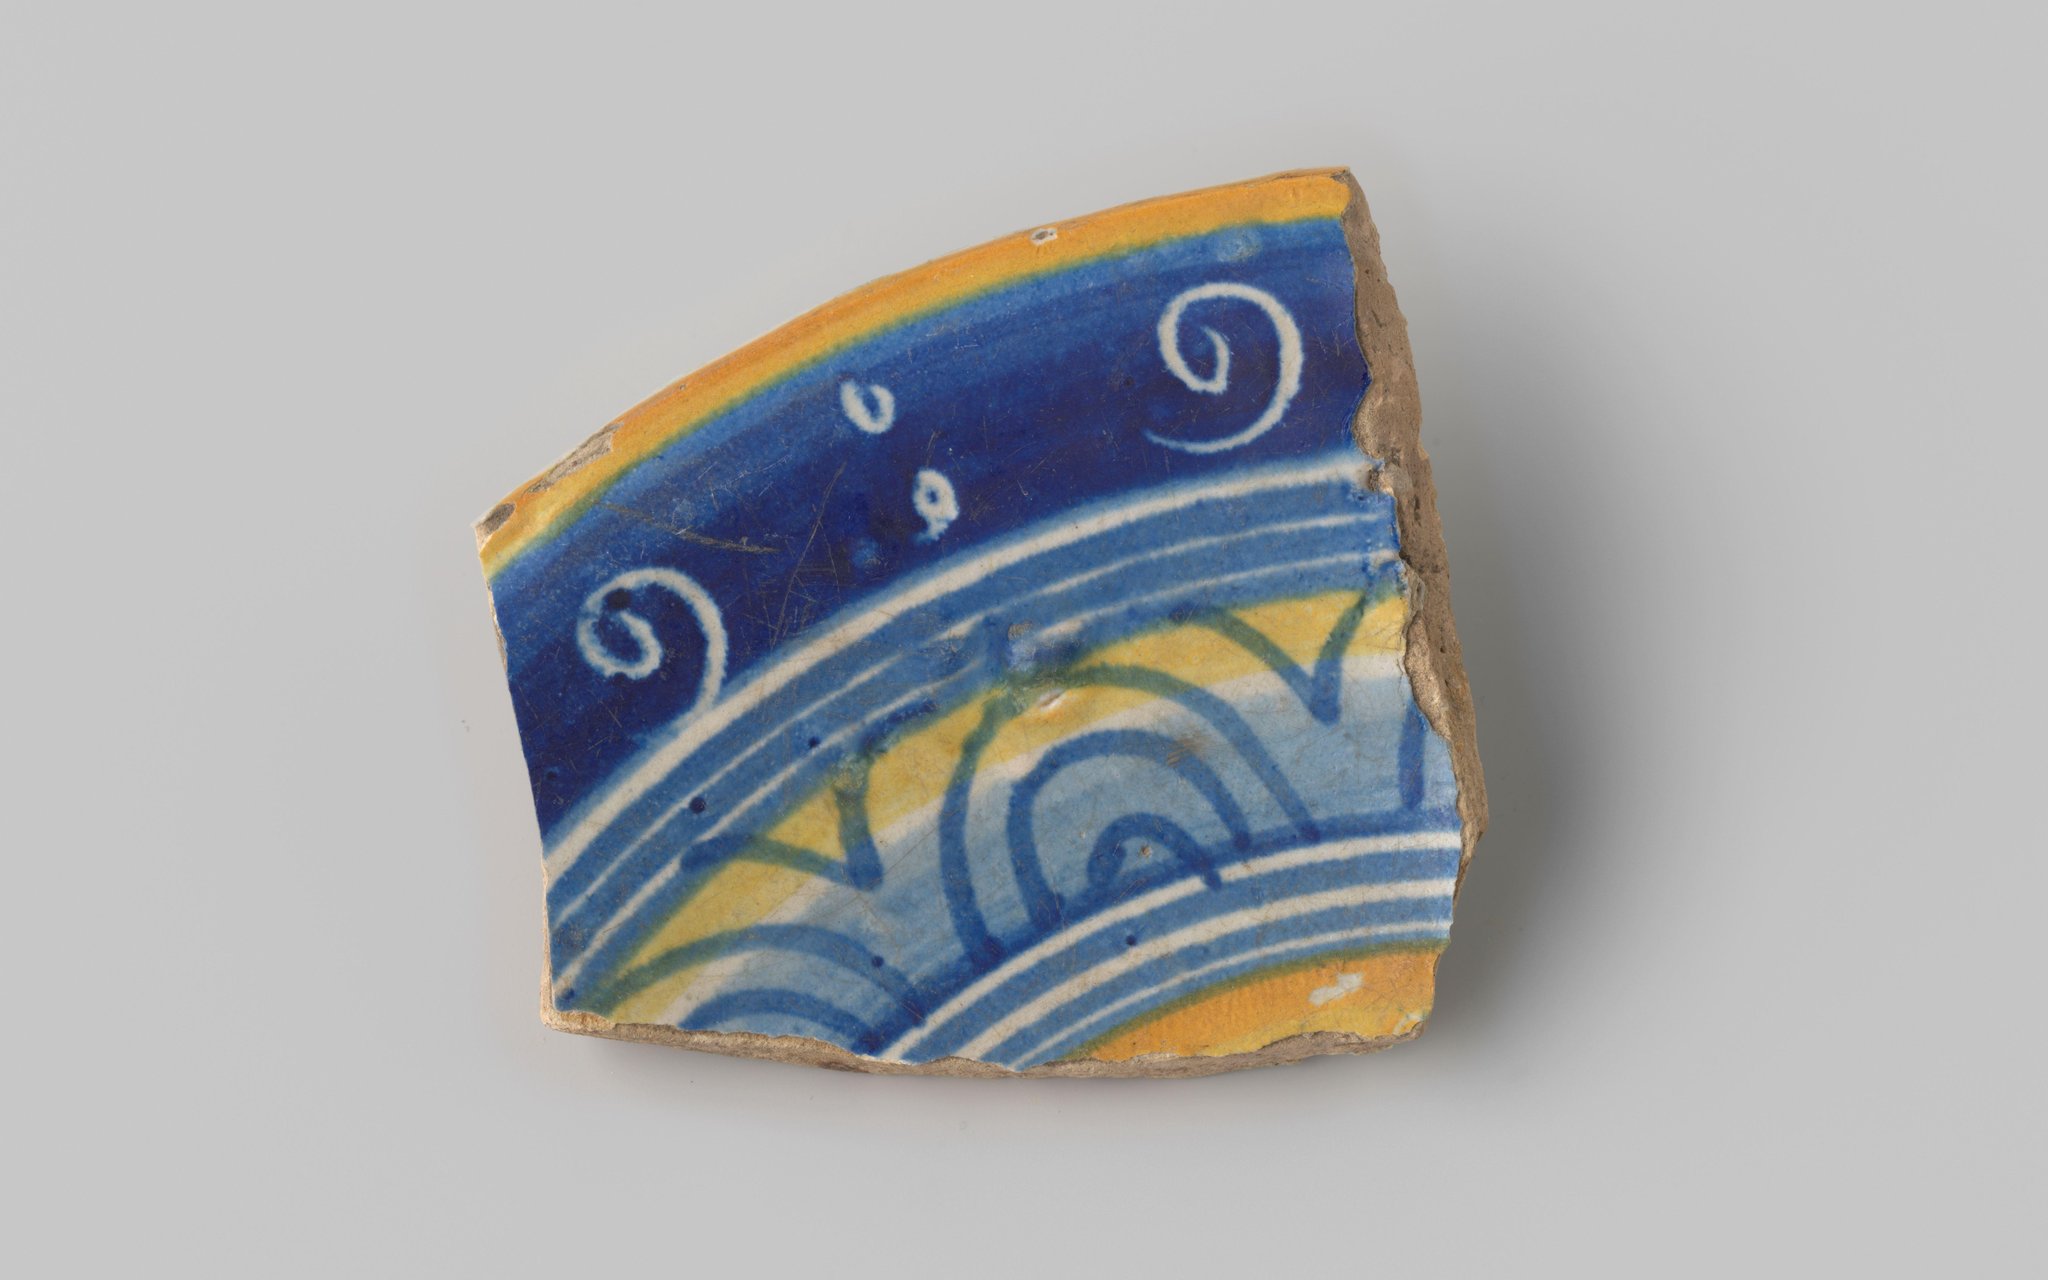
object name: sherd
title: Scherf veelkleurig majolica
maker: Anonymous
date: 1500-1699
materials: earthenware, glaze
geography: northern netherlands